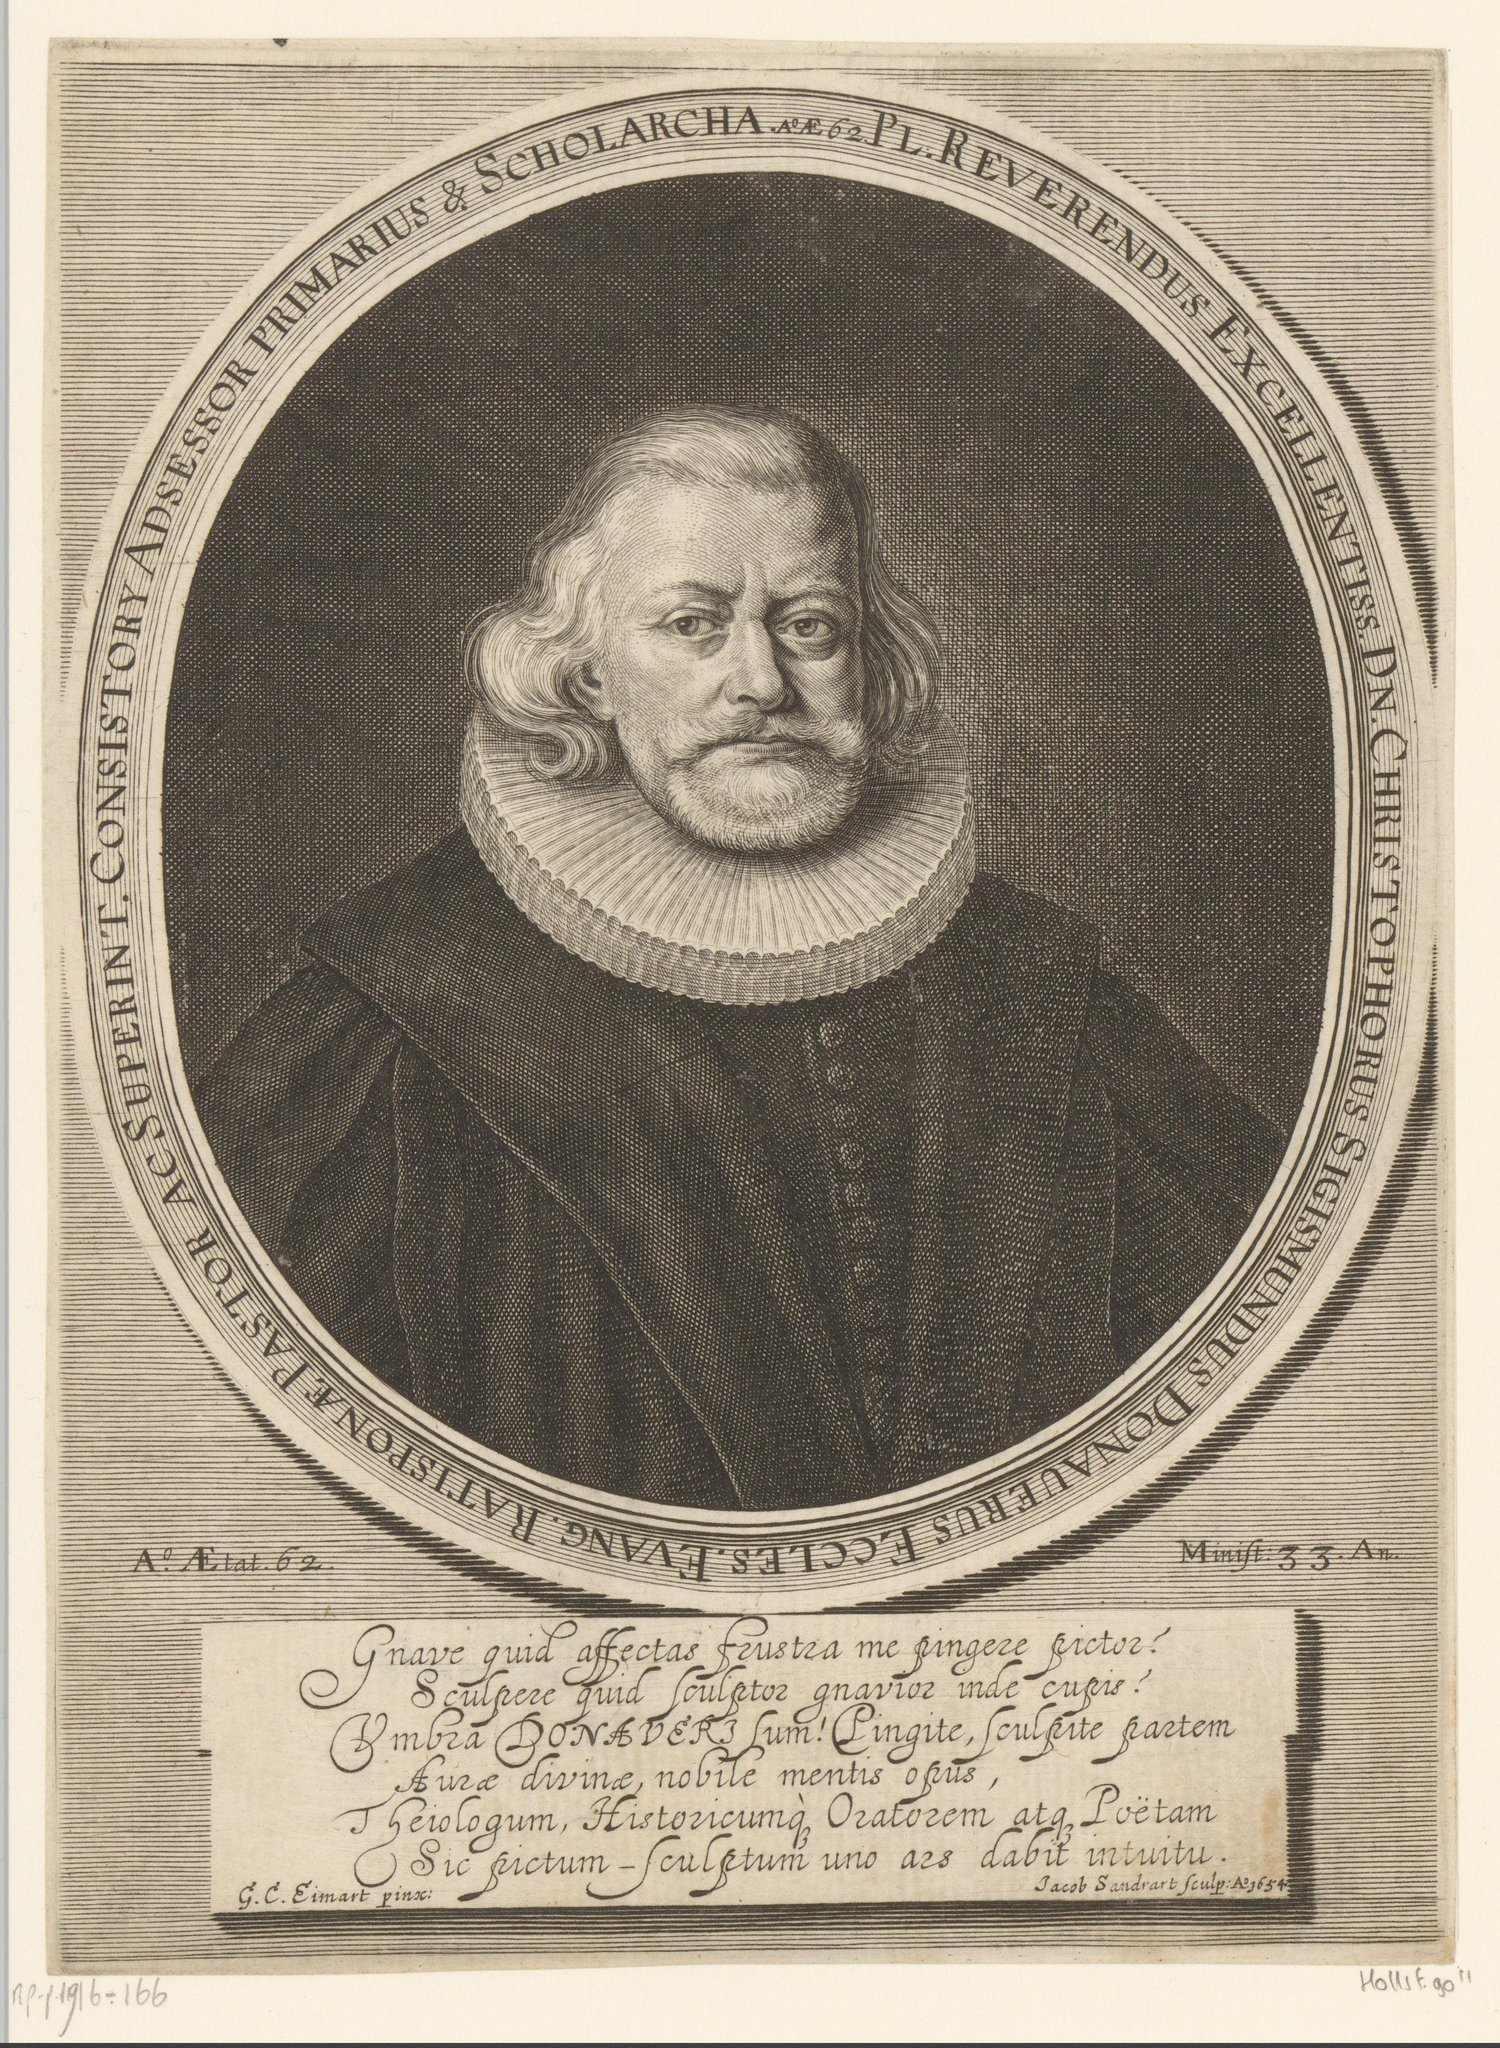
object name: print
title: Portret van Christoph Sigmund Donauer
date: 1654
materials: paper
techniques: engraving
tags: christoph sigmund i donauer, historical persons, armorial bearing, heraldry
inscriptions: collector's mark: Lugt 2228